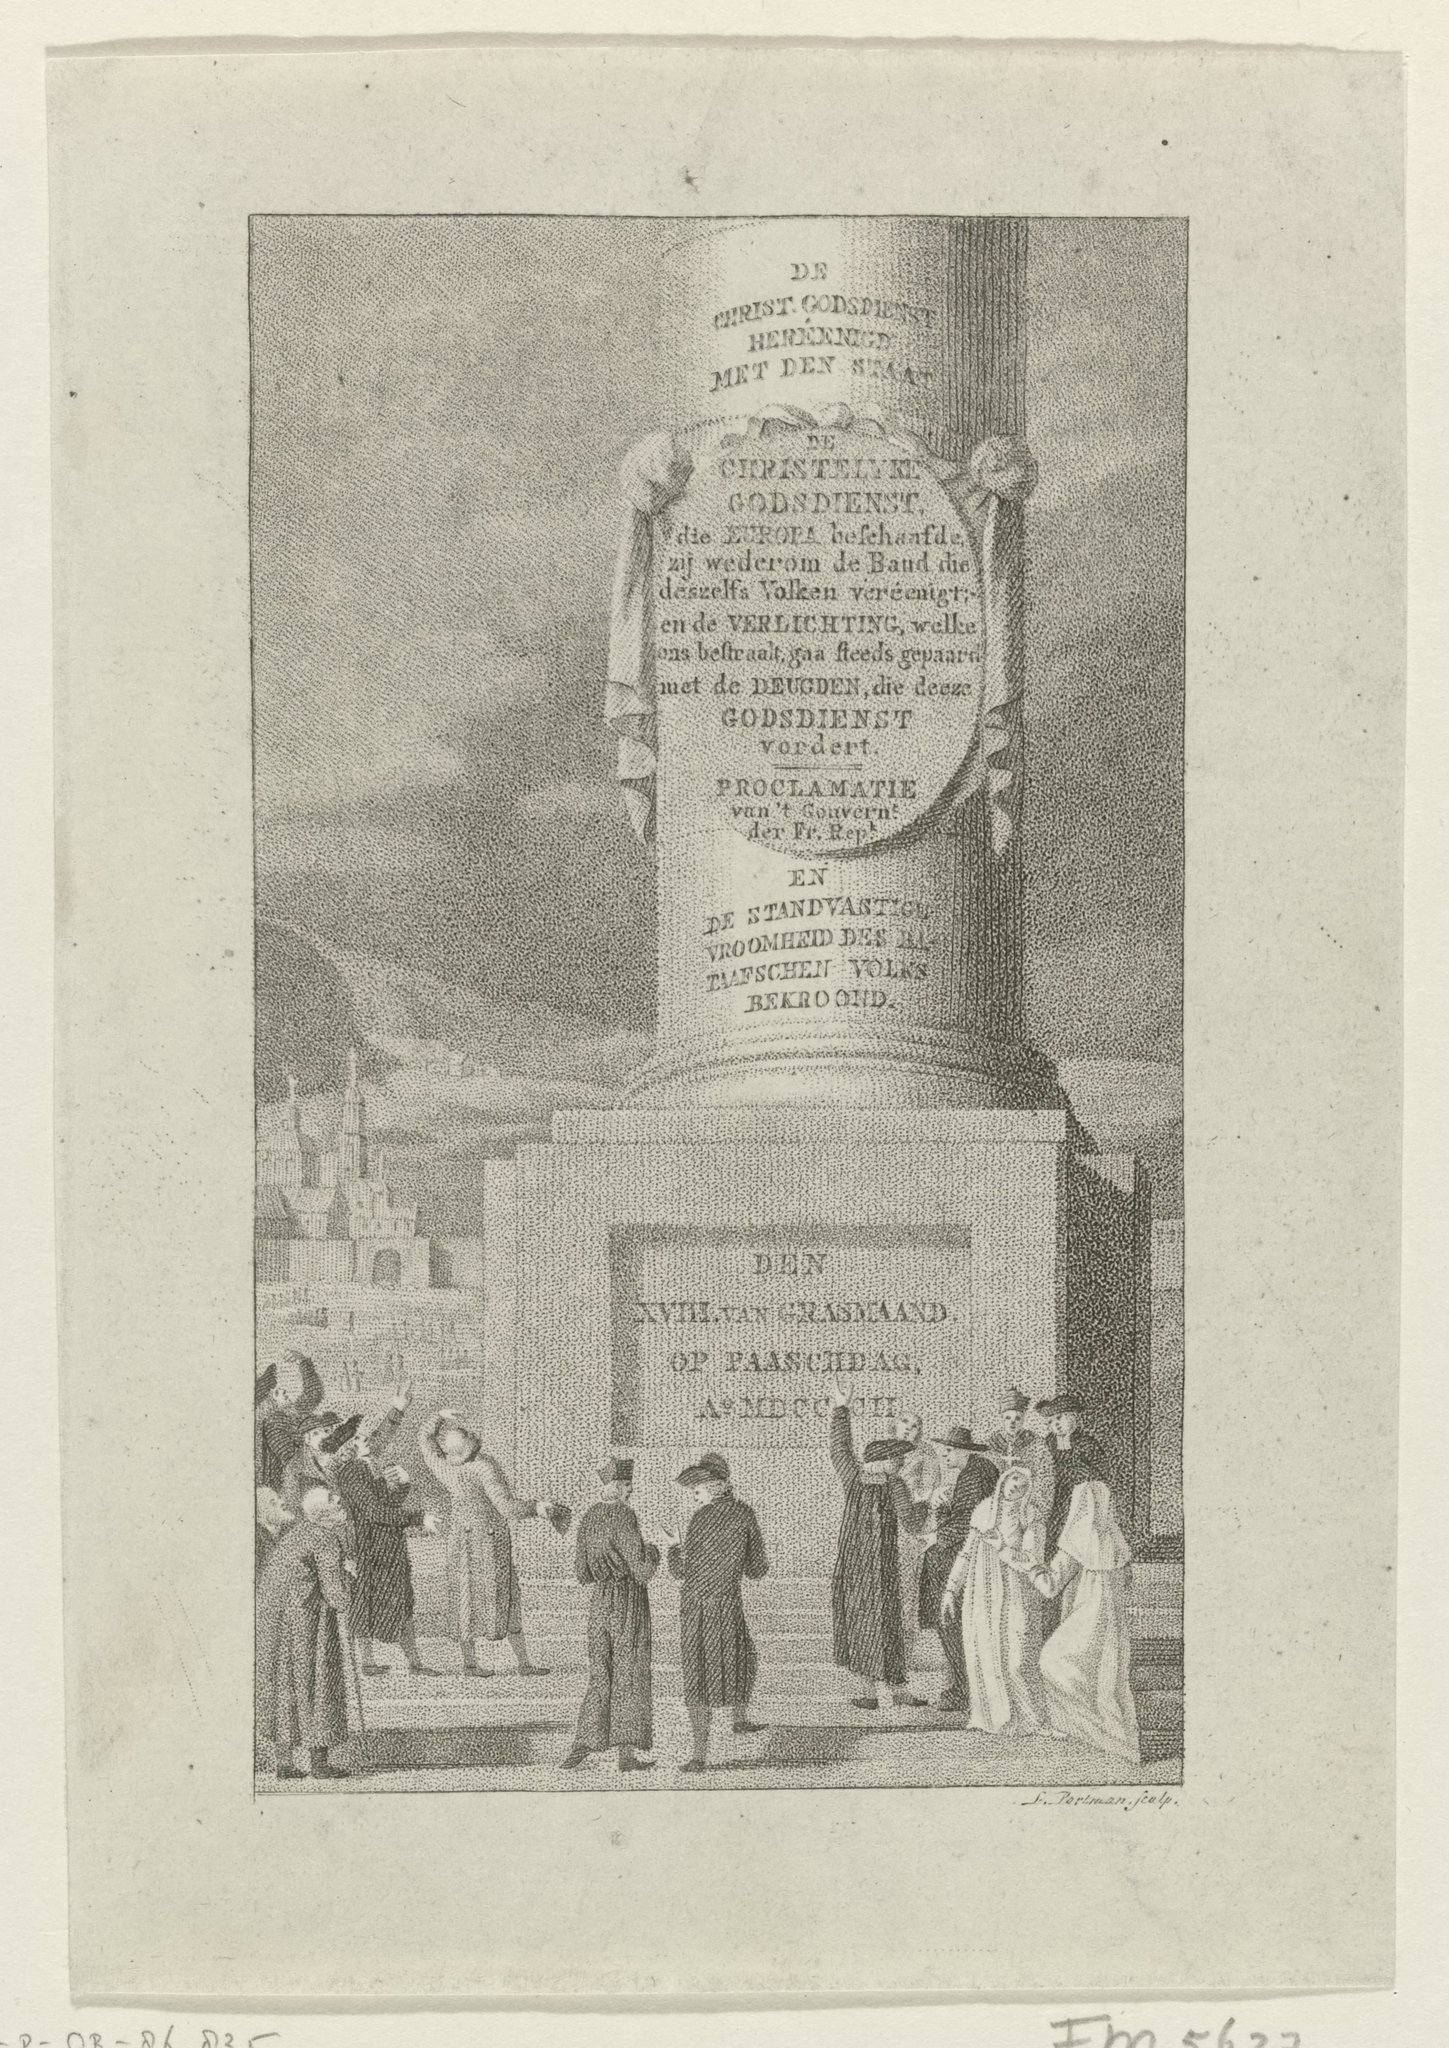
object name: print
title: Allegorie op het herstel van Christelijke godsdienst in de Bataafse Republiek, 1802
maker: ludwig gottlieb portman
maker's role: print maker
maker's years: 1772-1828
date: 1802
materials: paper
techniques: engraving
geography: netherlands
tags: allegorical and symbolical representations ~ the church and religion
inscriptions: collector's mark: Lugt 2228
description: Allegorie op de proclamatie van 18 april 1802 waarbij de Christelijke godsdienst in de Franse en Bataafse Republiek werd hersteld. Figuren verzameld rondom een kolom waarop teksten staan.